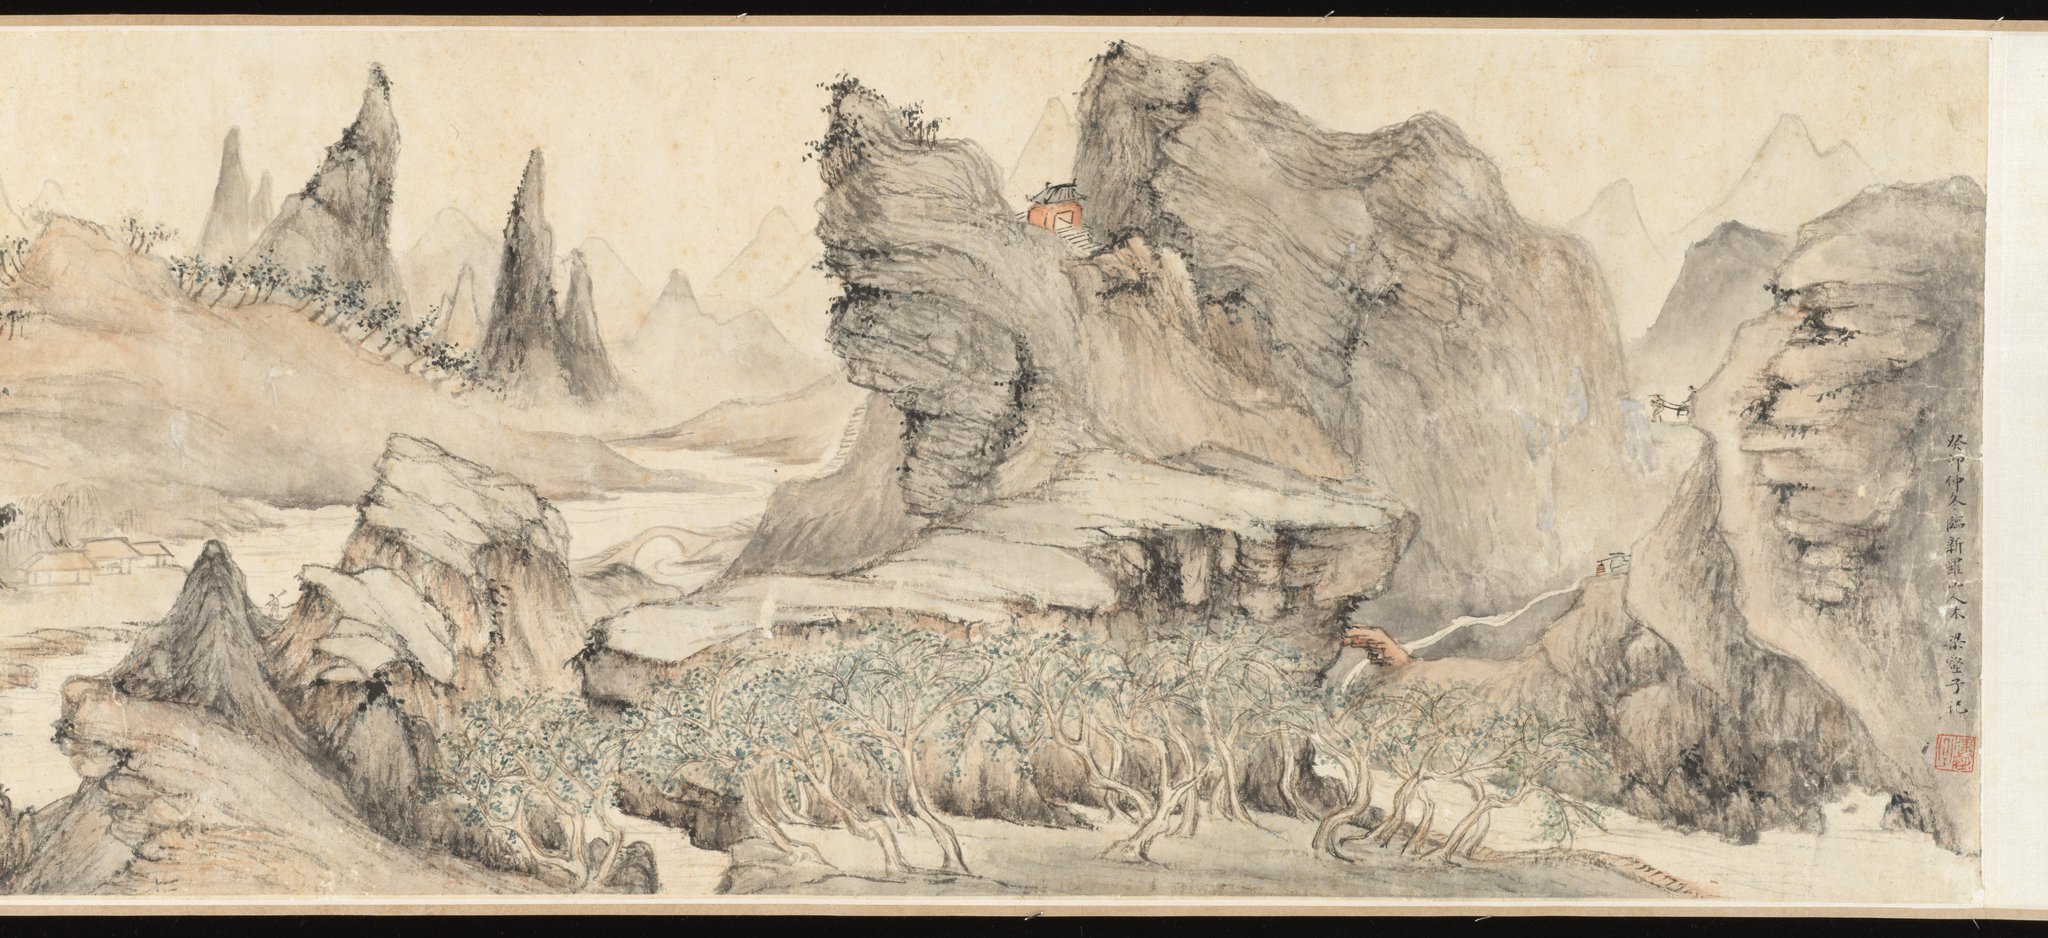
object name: handscroll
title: Landscape after Hua Yan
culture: chinese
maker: liu yanchong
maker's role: artist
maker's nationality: chinese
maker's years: 1808-1847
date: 1843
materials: ink, paper